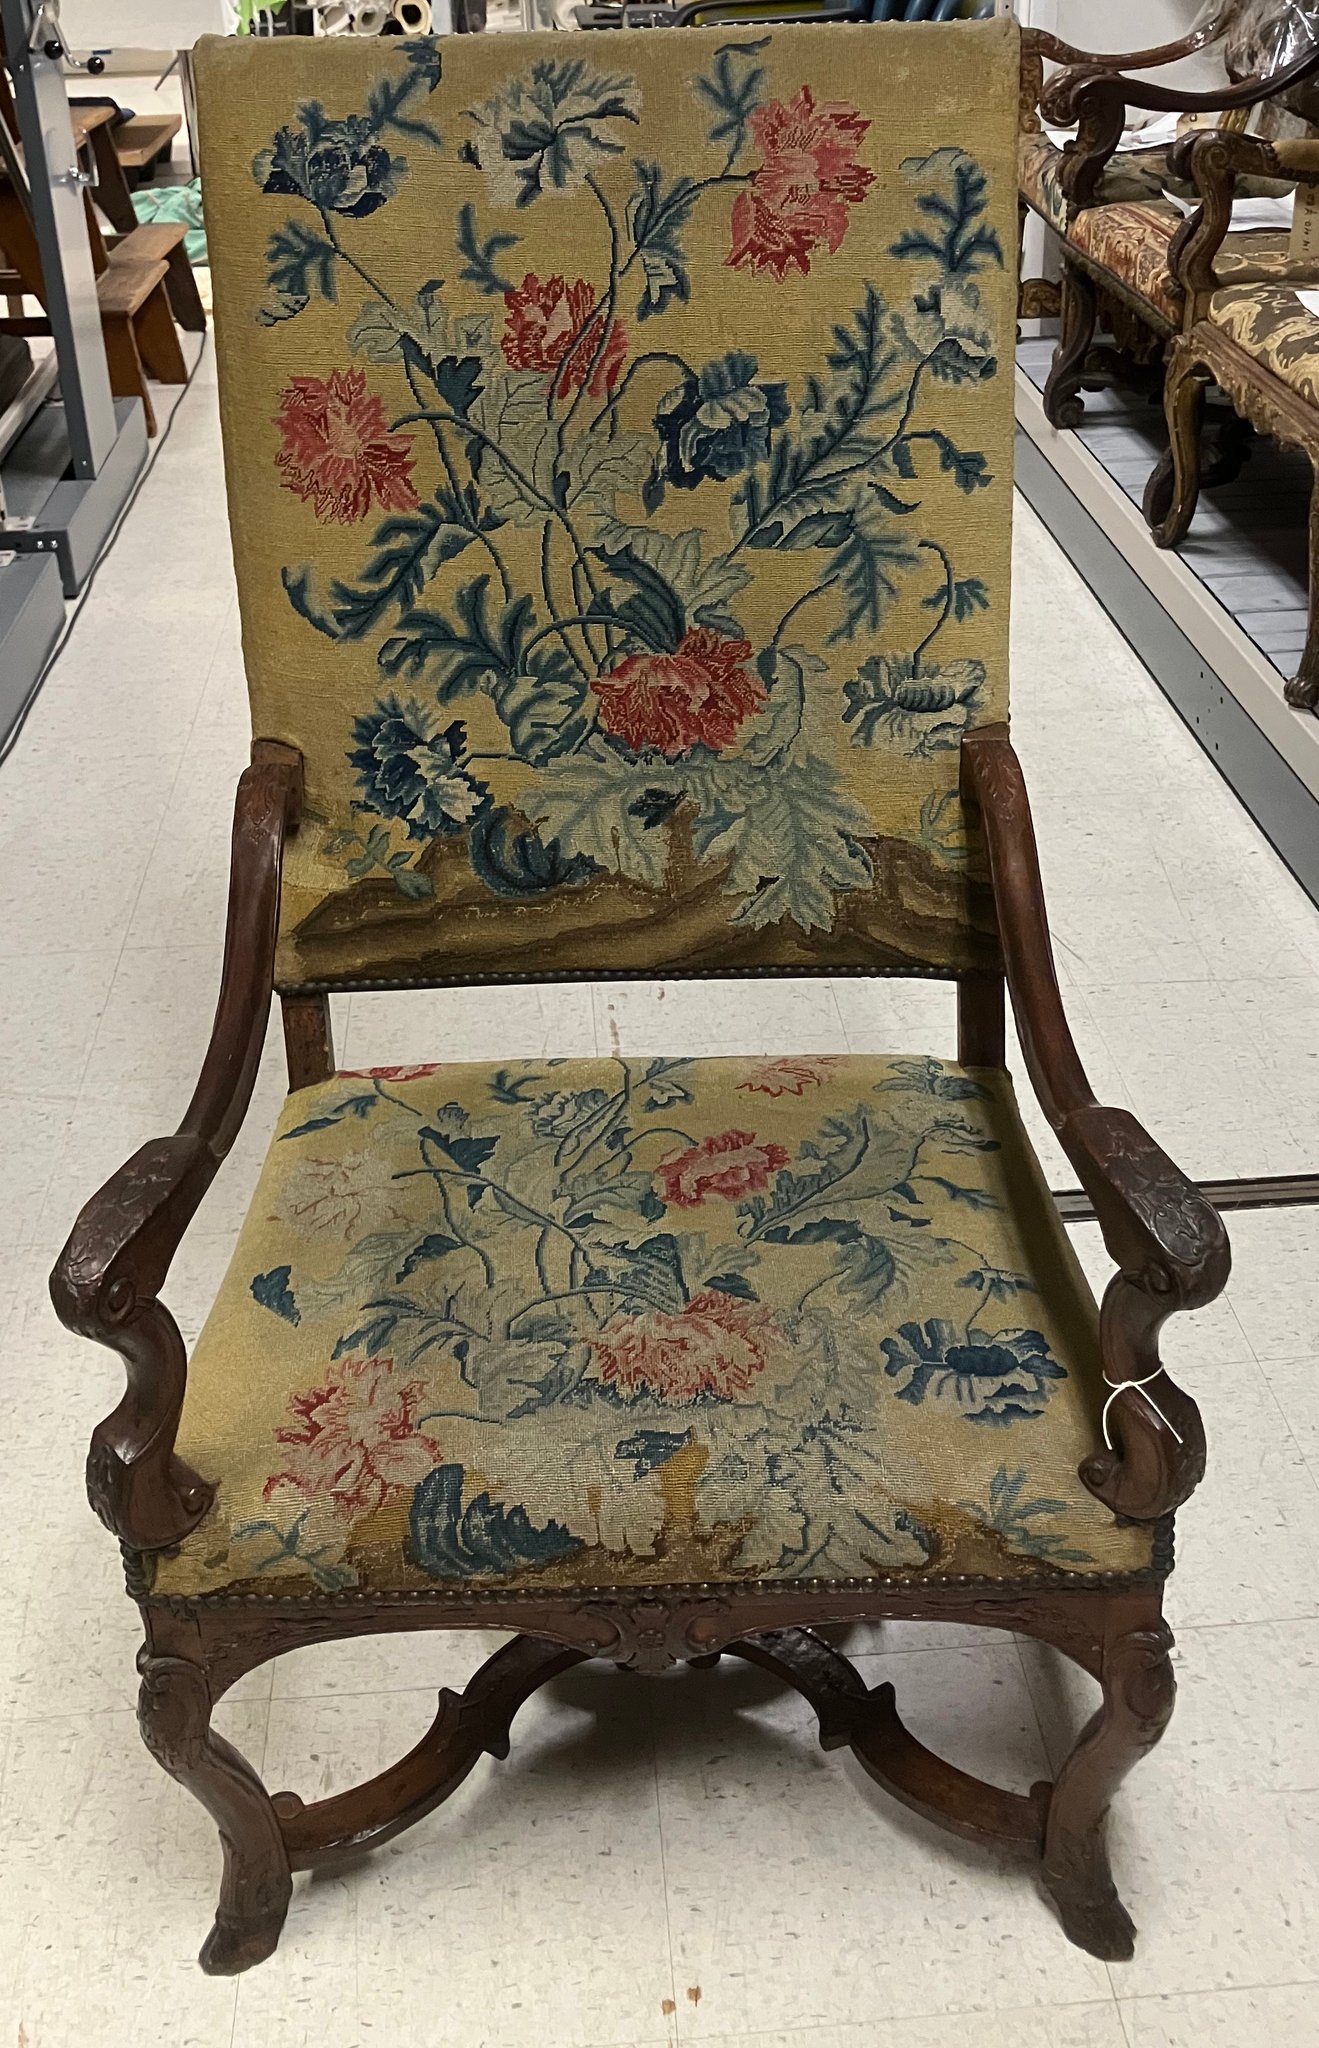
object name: armchair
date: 1667-1700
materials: wood, wax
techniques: carving, embroidery, polish